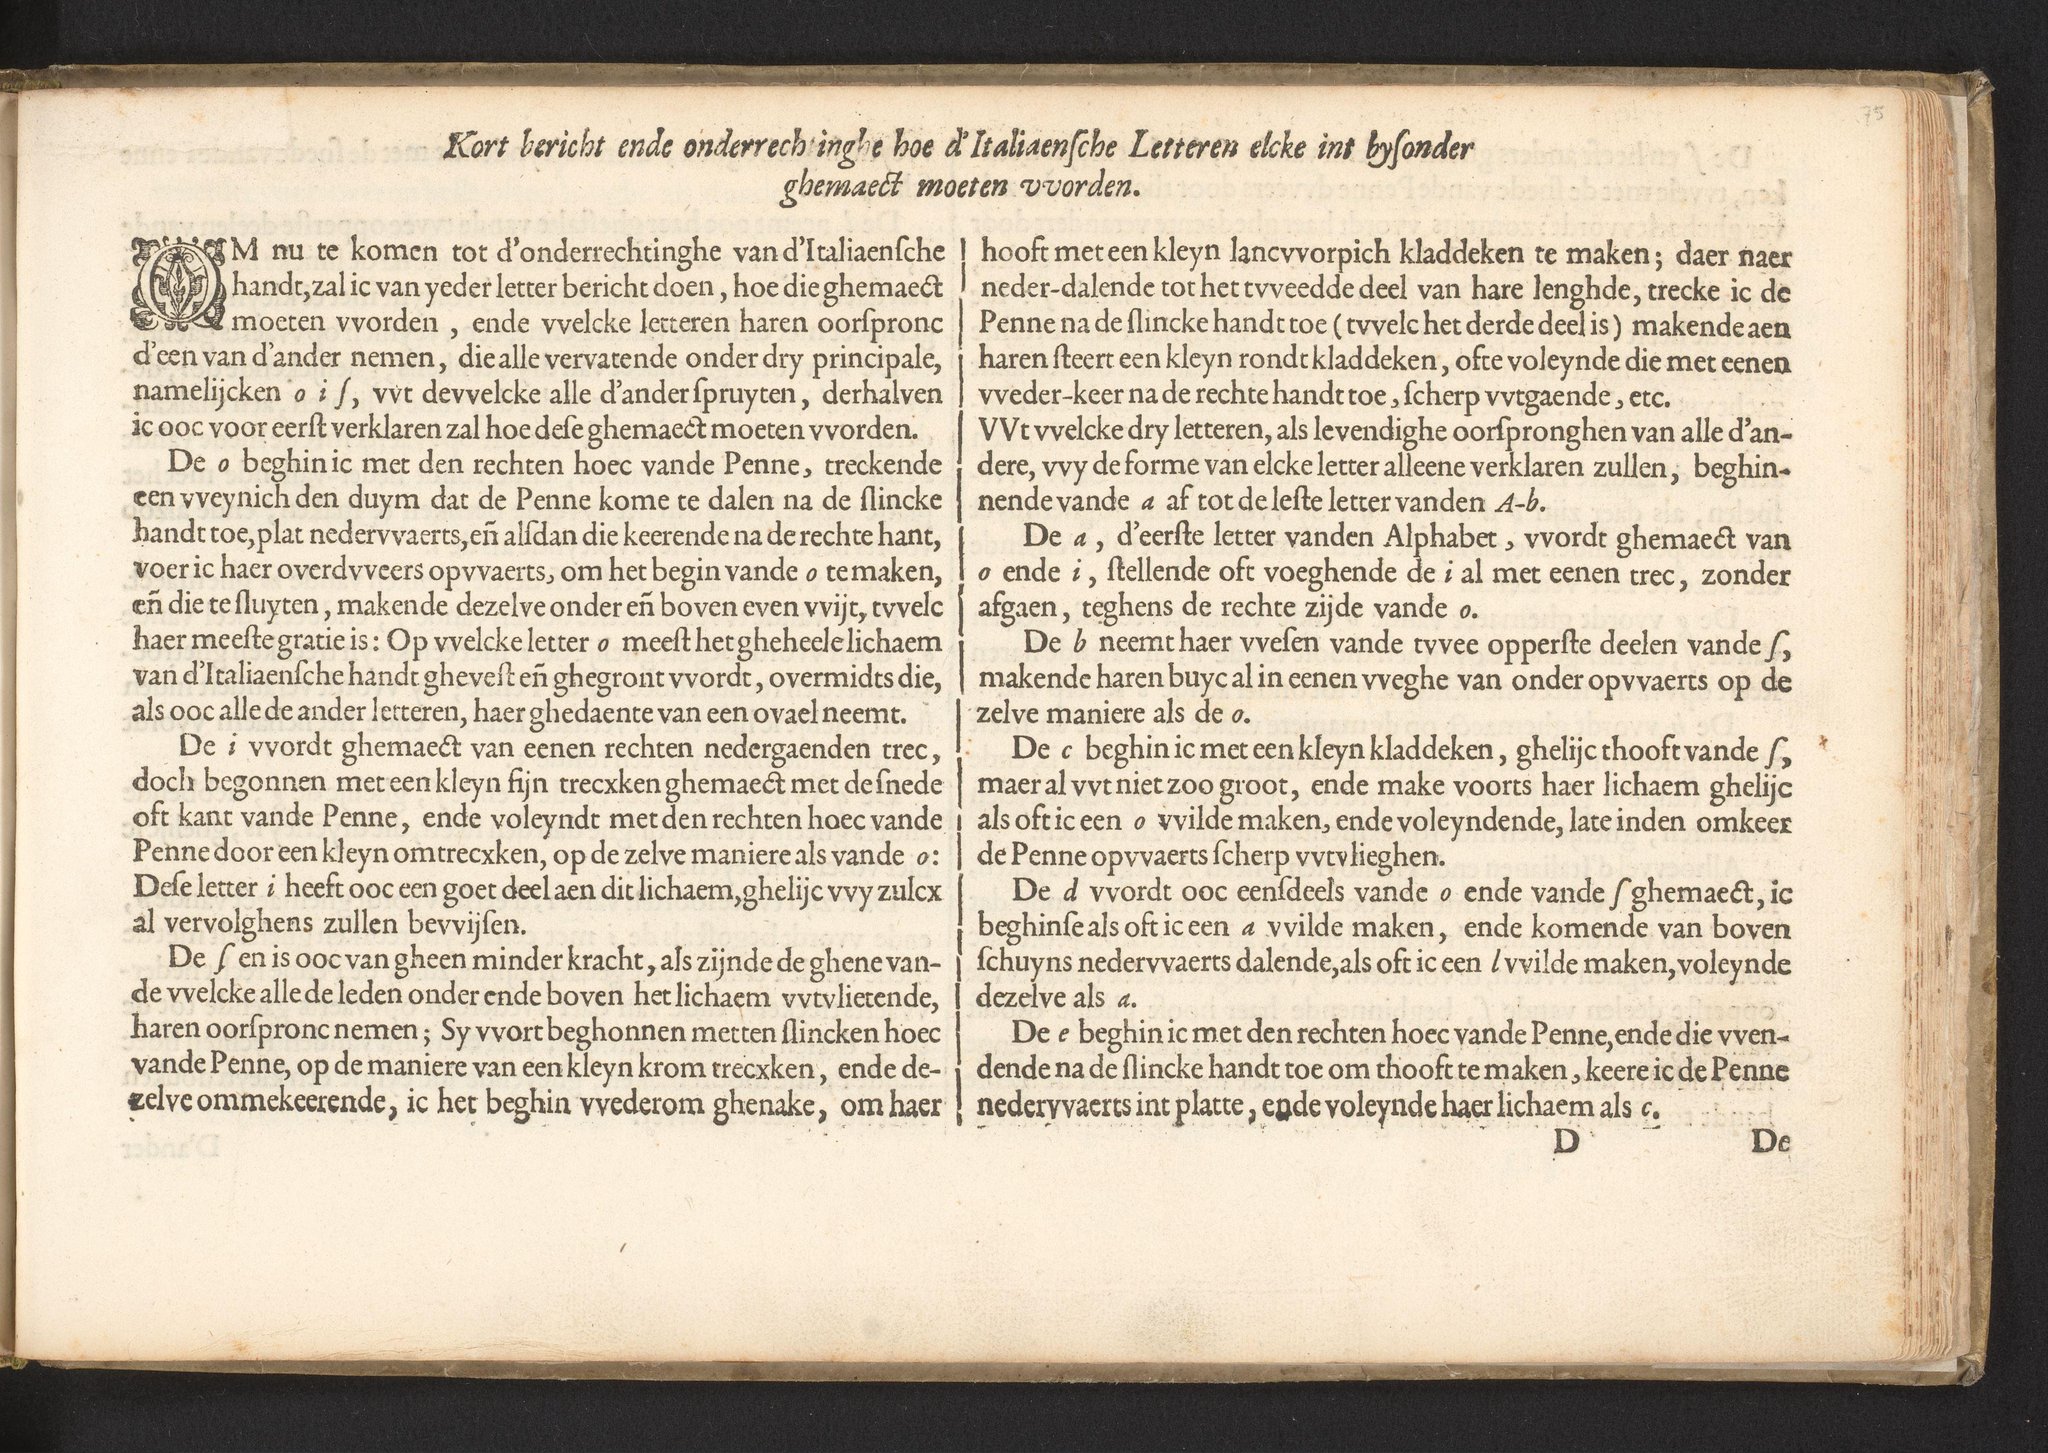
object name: album leaf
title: Kort bericht ende onderrechtinghe hoe d'Italiaensche Letteren elcke int bysonder ghemaect moeten worden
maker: jan van de velde (i)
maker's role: painter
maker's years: 1568-1623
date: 1605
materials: paper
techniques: letterpress printing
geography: rotterdam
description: Folio D1r met een instructie hoe de Italiaanse letter geschreven moet worden. De tekst vangt aan met een kleine initiaal O. Het blad maakt deel uit van een album.